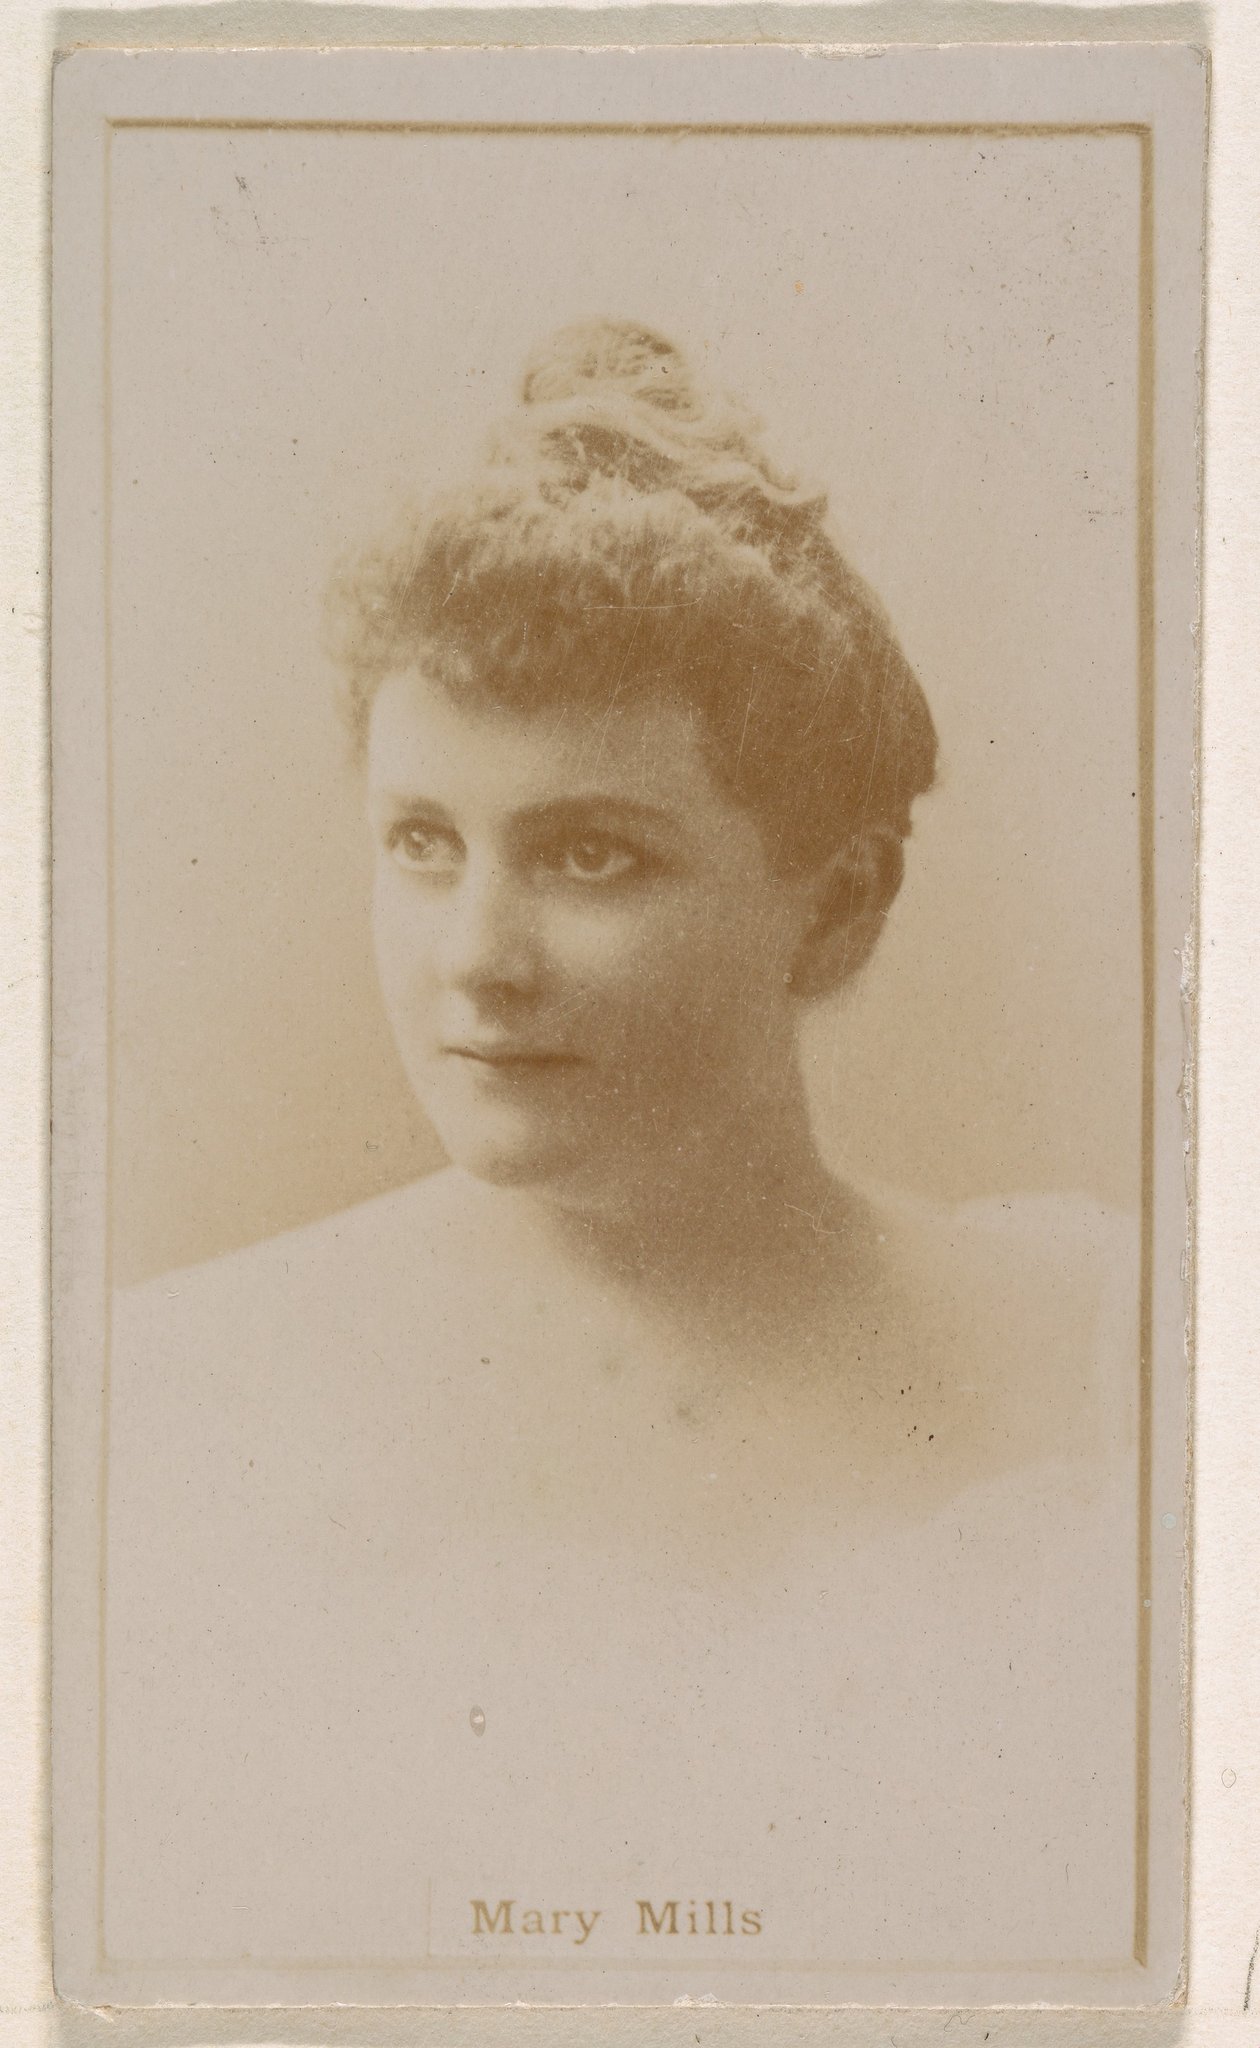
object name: photograph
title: Mary Mills, from the Actresses series (N245) issued by Kinney Brothers to promote Sweet Caporal Cigarettes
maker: kinney brothers tobacco company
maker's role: publisher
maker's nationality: american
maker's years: 1869-2011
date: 1890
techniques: albumen silver print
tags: portraits,women,actresses